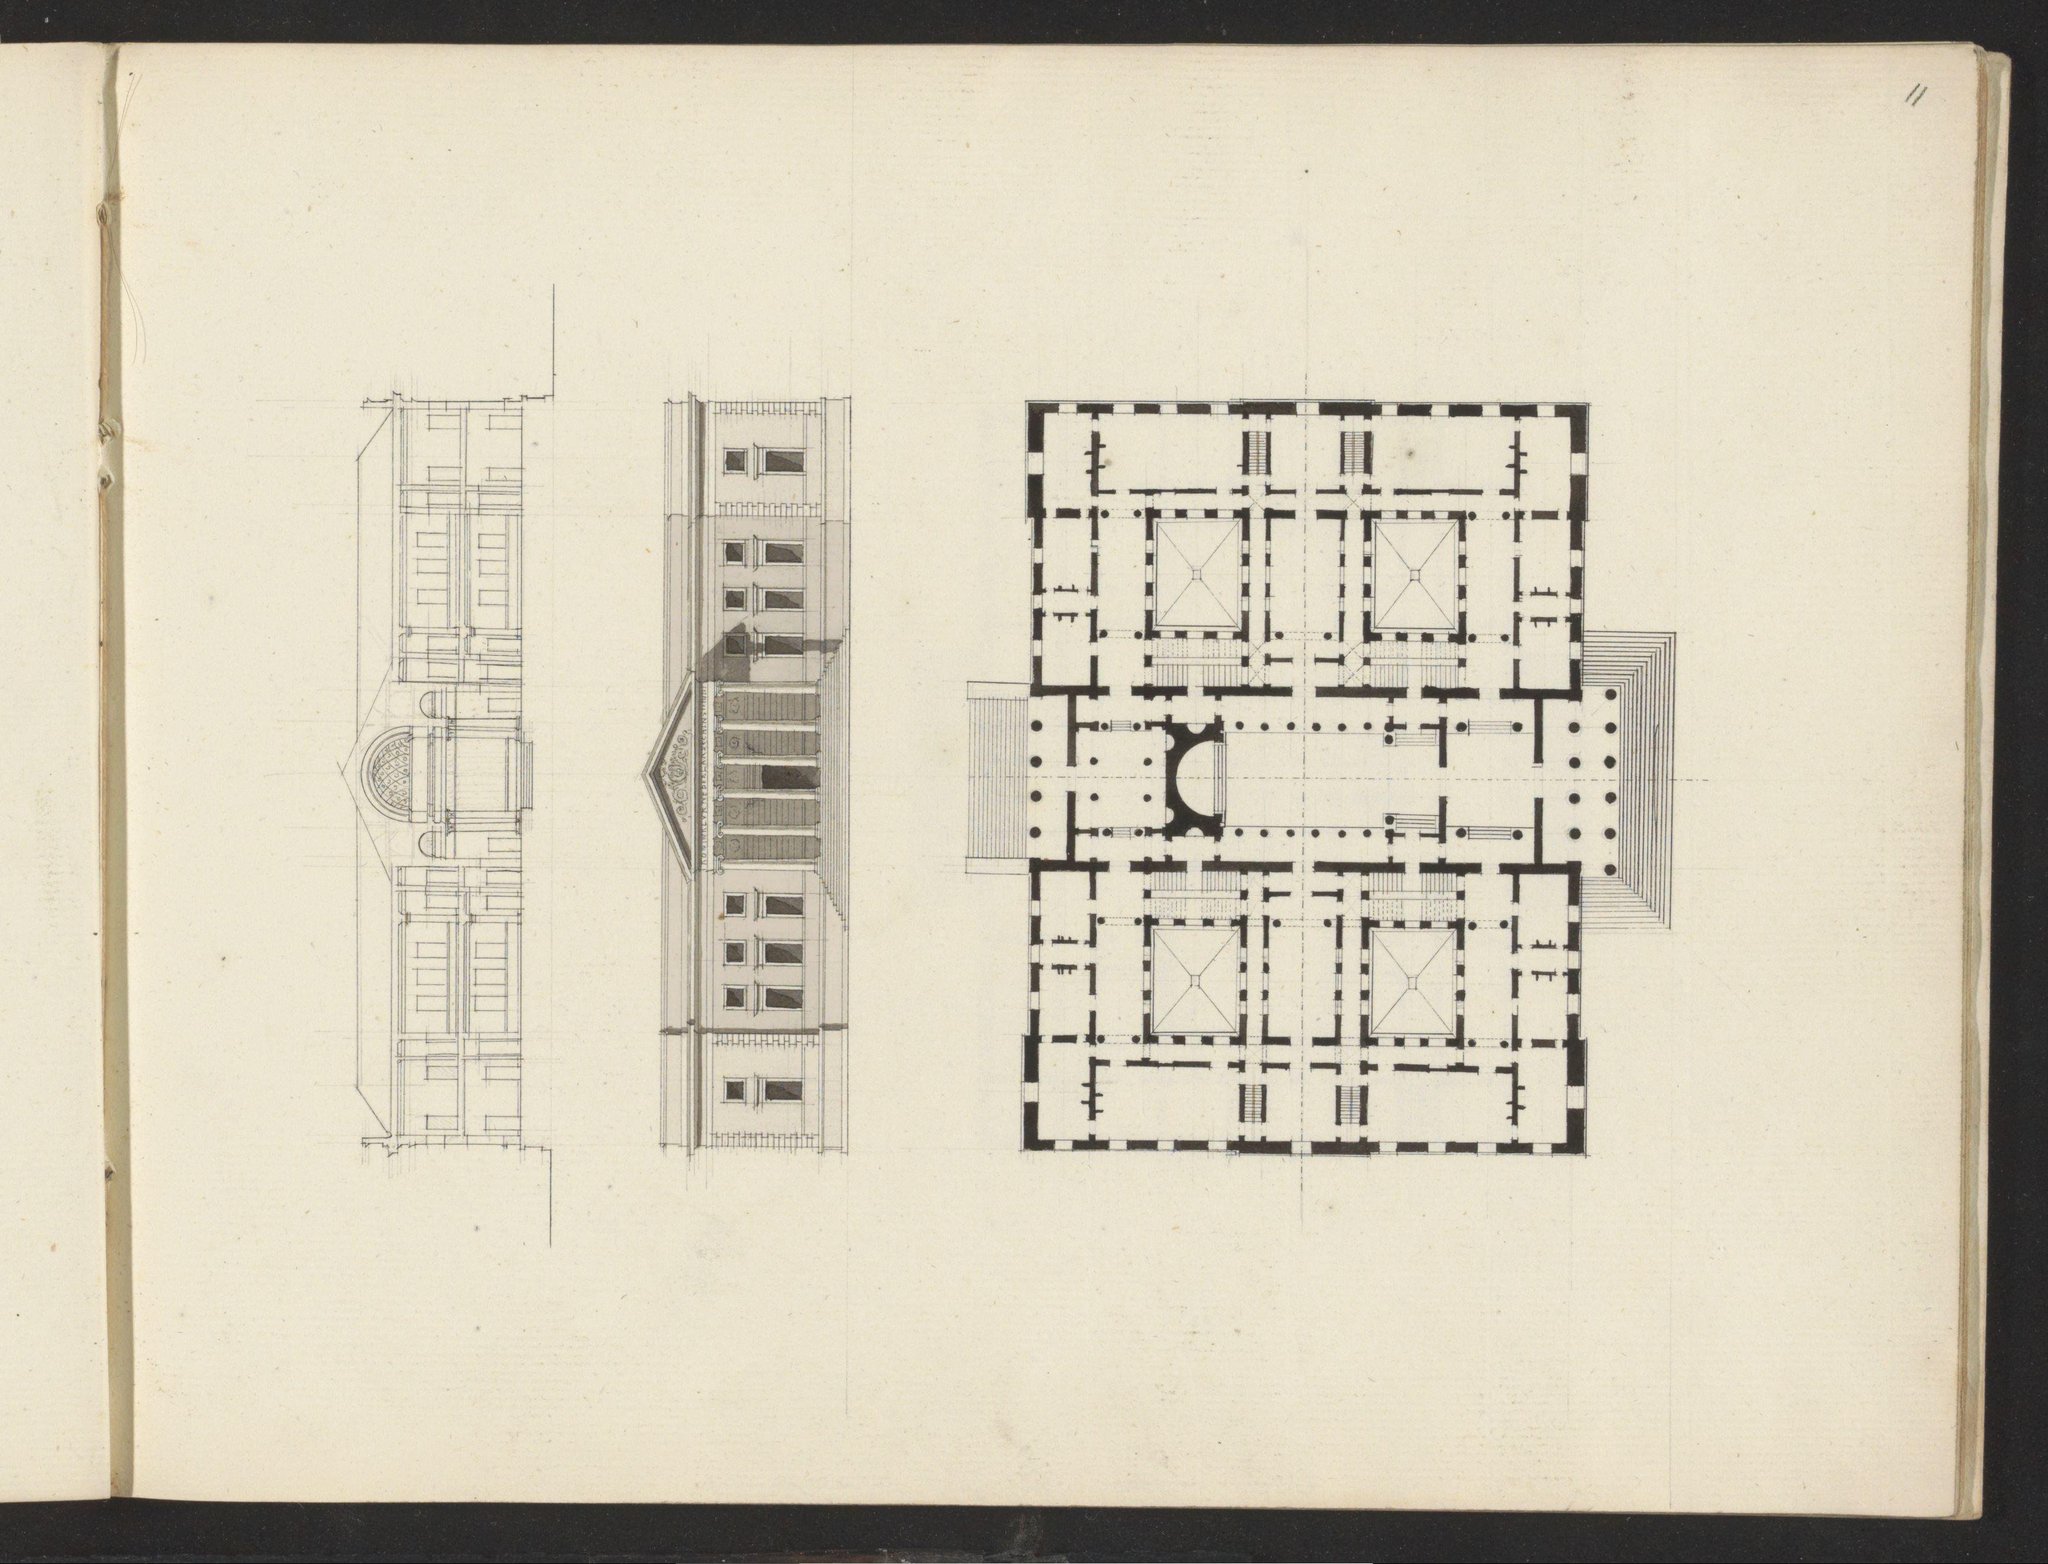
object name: sketchbook leaf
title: Plattegrond, voorgevel en doorsnede van een gebouw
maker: willem springer jr.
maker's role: draughtsman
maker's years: 1815-1907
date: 1825-1907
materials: ink, paper, pencil, watercolor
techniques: brush, pen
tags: façade (of house or building), plan ~ architecture, section ~ architectural design or model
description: Pagina 11 uit een schetsboek met 28 pagina's.